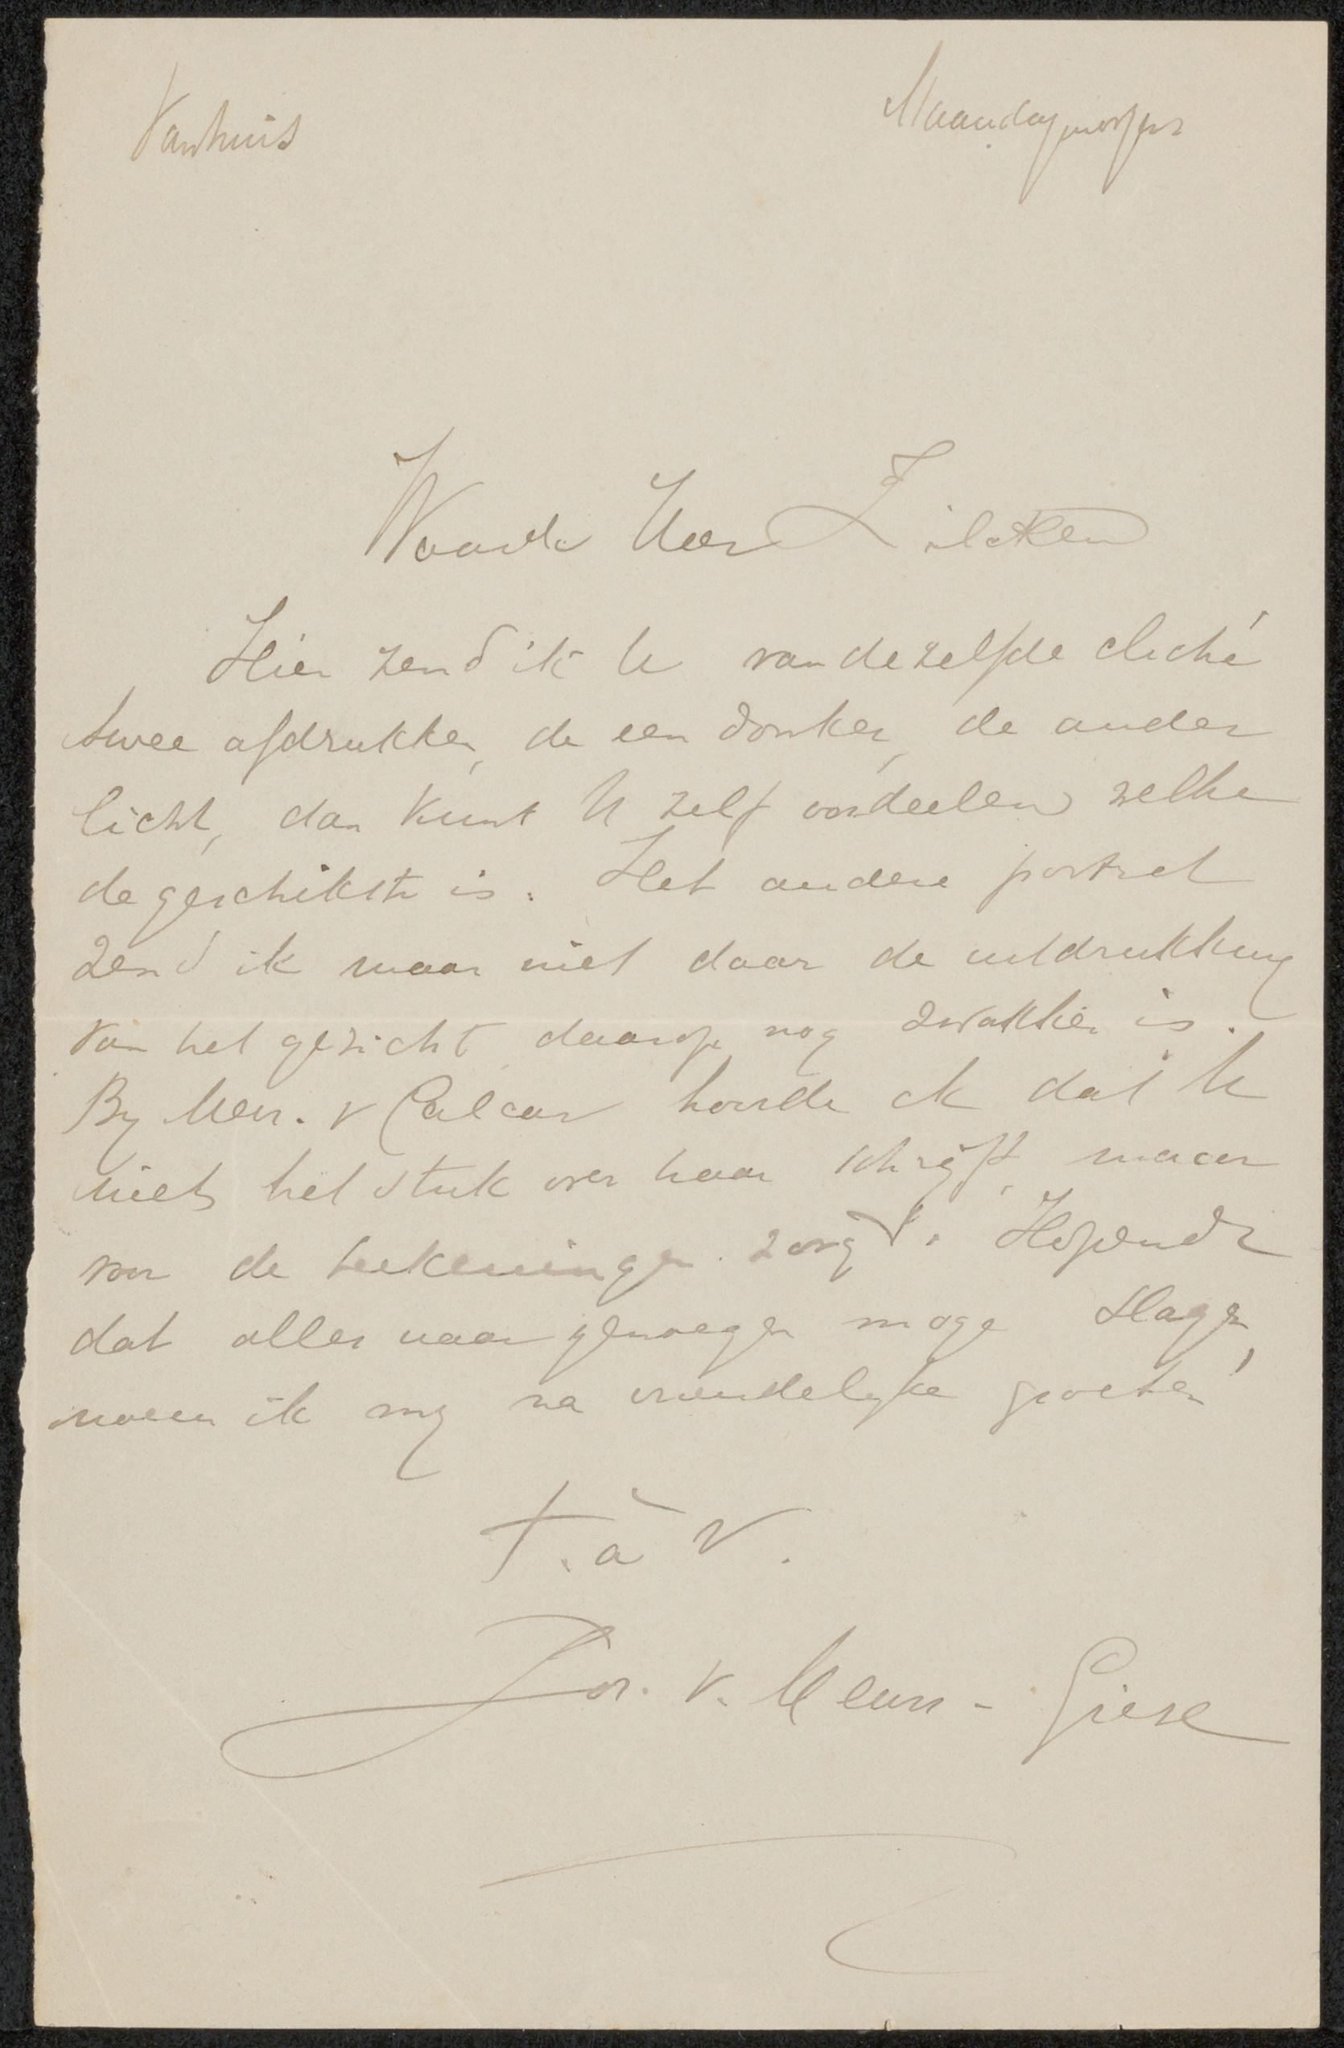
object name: letter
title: Brief aan Philip Zilcken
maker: josephine giese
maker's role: auteur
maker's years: 1856-1926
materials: ink, paper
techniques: pen, writing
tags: painter, draughtsman, geesje mesdag-van calcar, philip zilcken, photography, cinematography, anonymous historical person portrayed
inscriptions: collector's mark: ‘RPK’